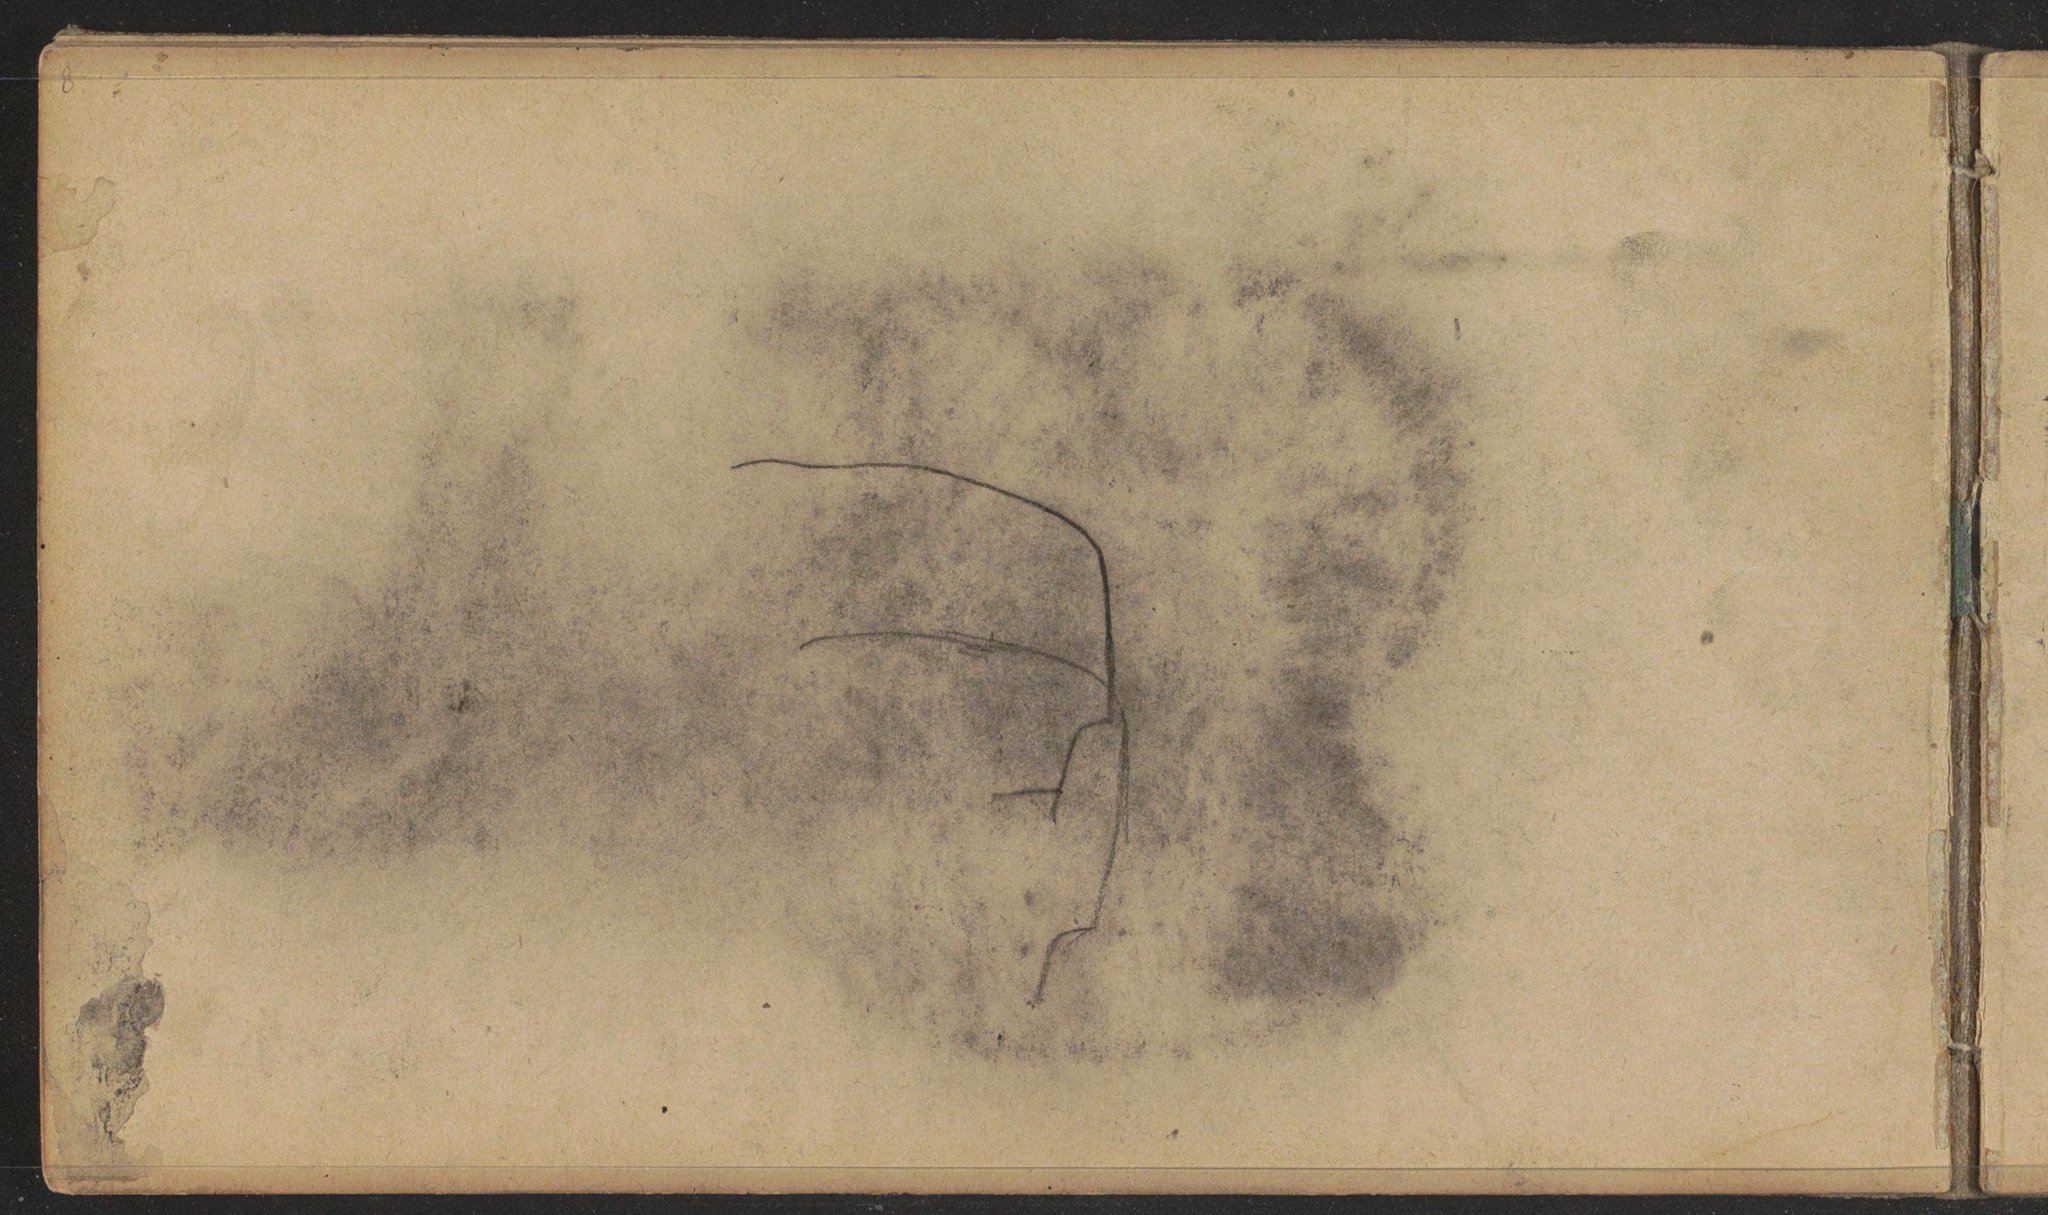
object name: sketchbook leaf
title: Studie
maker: willem witsen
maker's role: draughtsman, painter, print maker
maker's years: 1860-1923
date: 1887-1897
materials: chalk, paper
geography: amsterdam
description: Pagina 8 uit een schetsboek met 25 bladen.